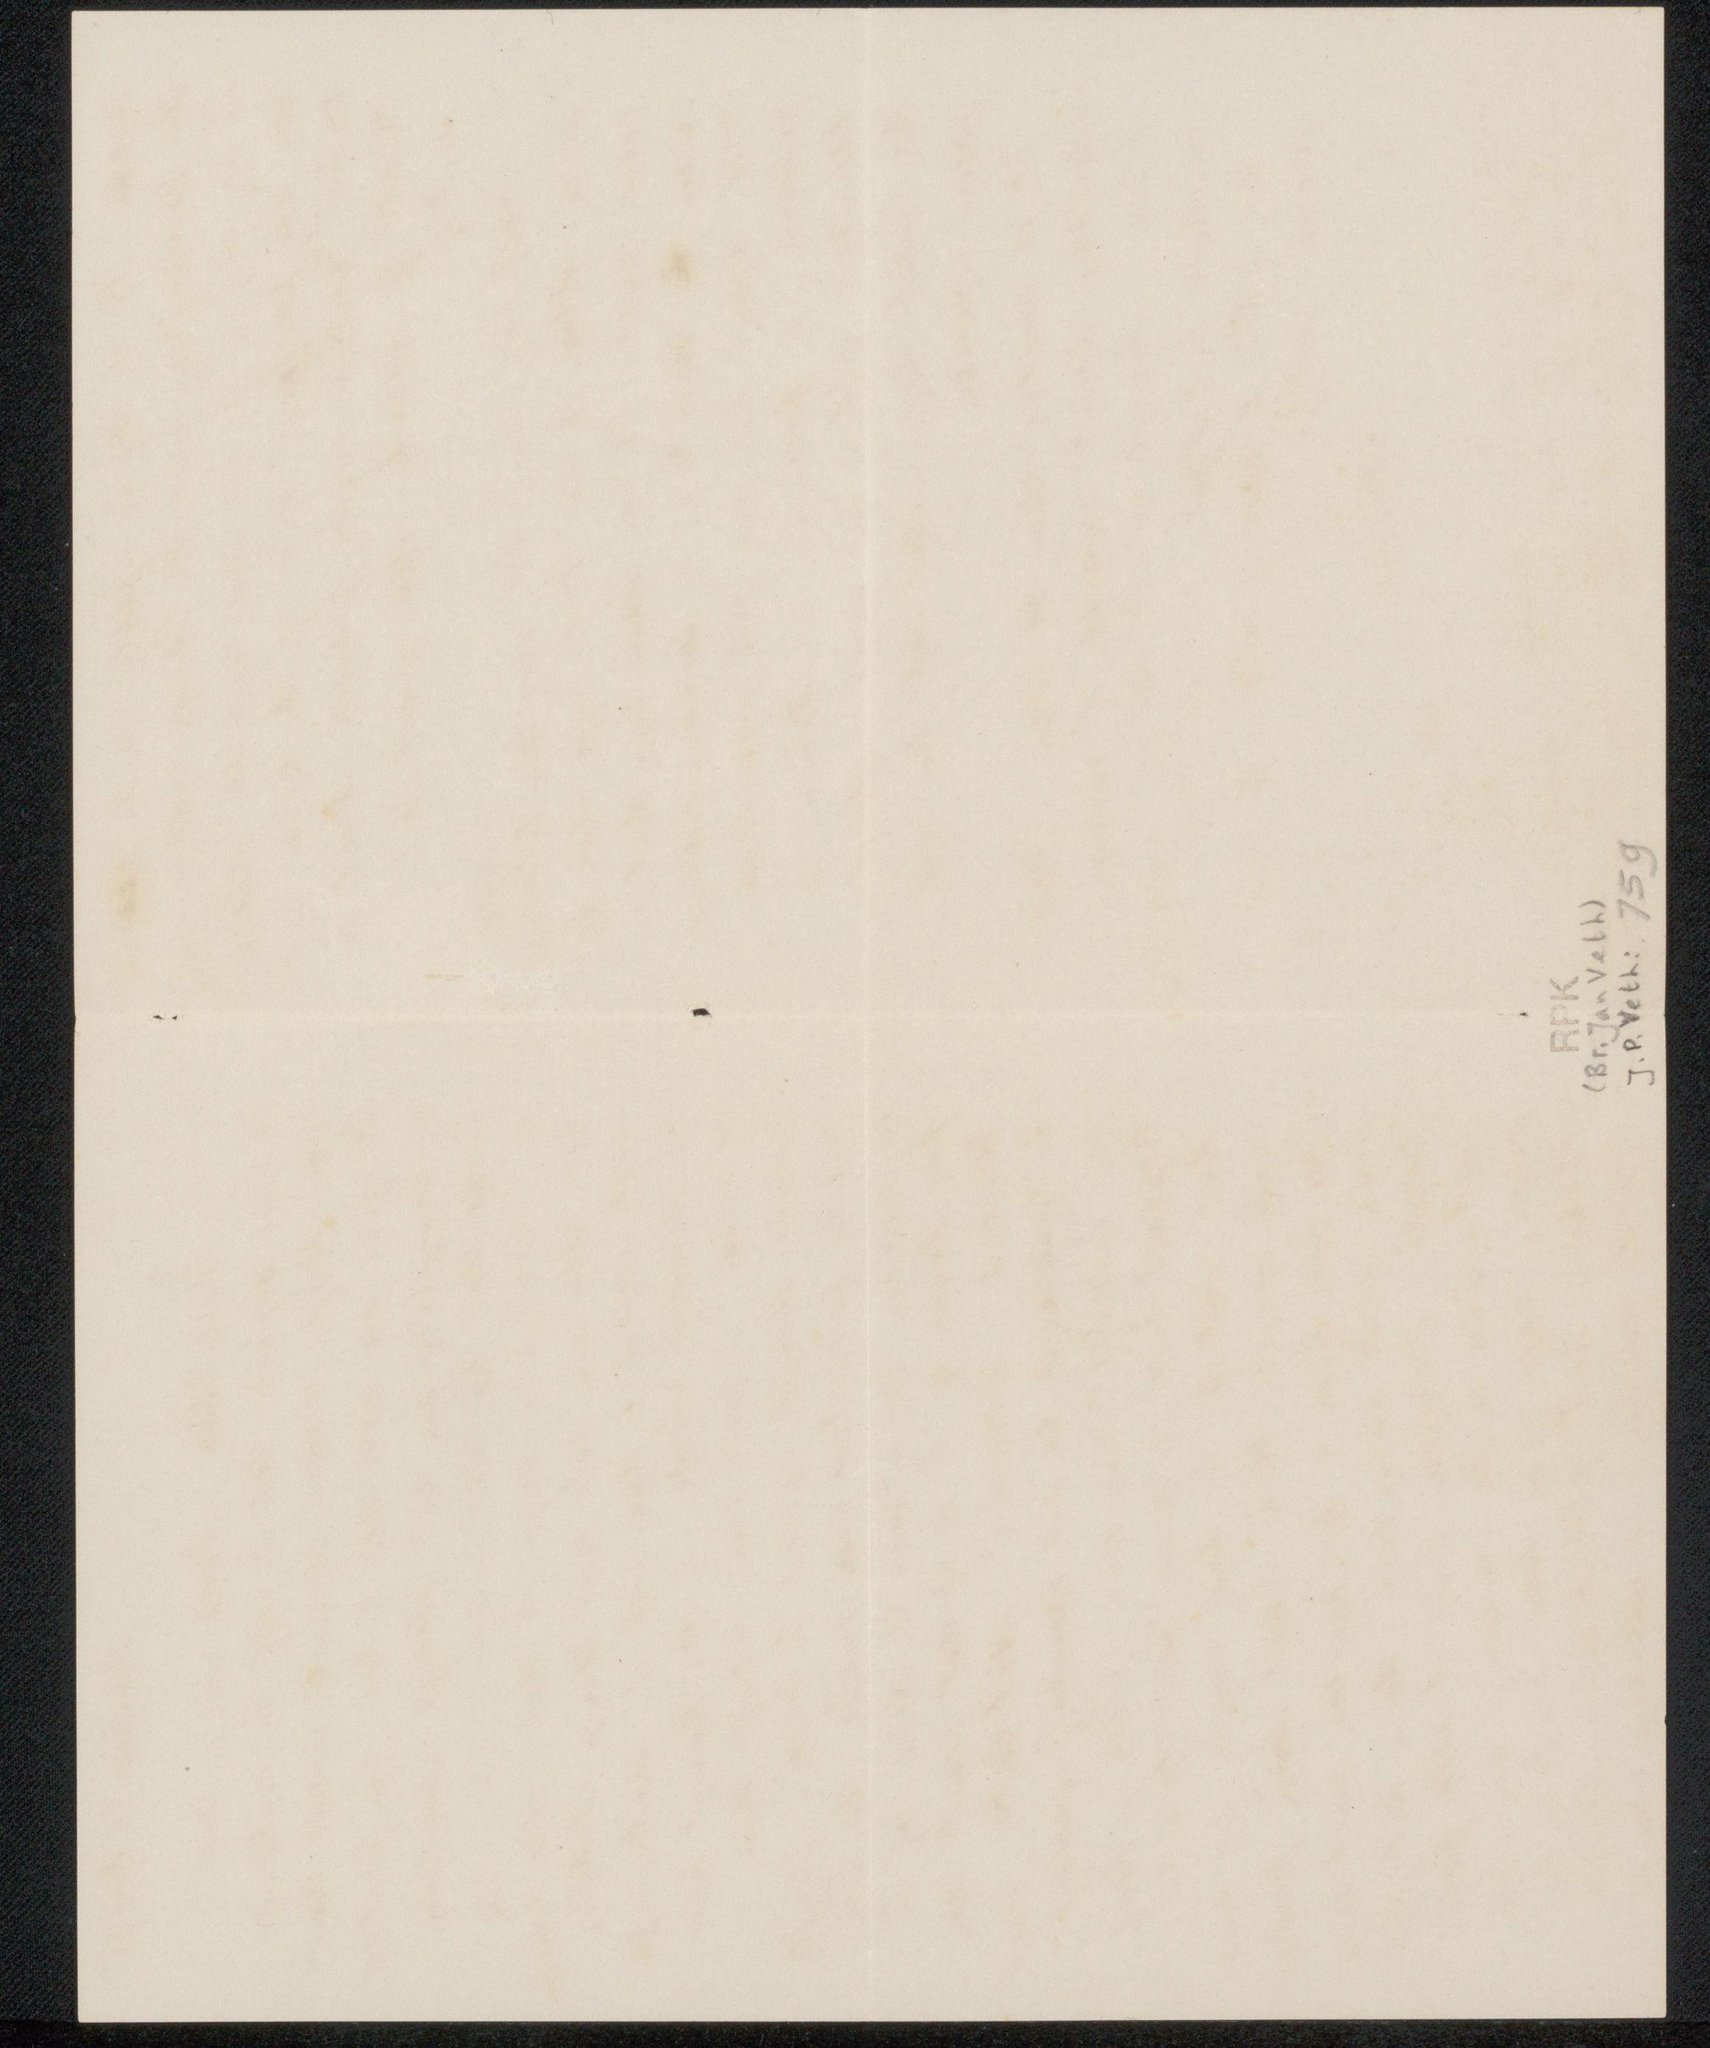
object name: letter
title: Brief aan Etha Fles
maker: jan veth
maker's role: designer, draughtsman, painter, print maker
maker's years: 1864-1925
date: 1895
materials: ink, paper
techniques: pen, writing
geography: bussum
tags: the hague, jozef israëls, utrecht, print maker, etha fles, painting (including book-illumination, miniature-painting), historical persons (portraits and scenes from the life)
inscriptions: collector's mark: ‘RPK’, watermark